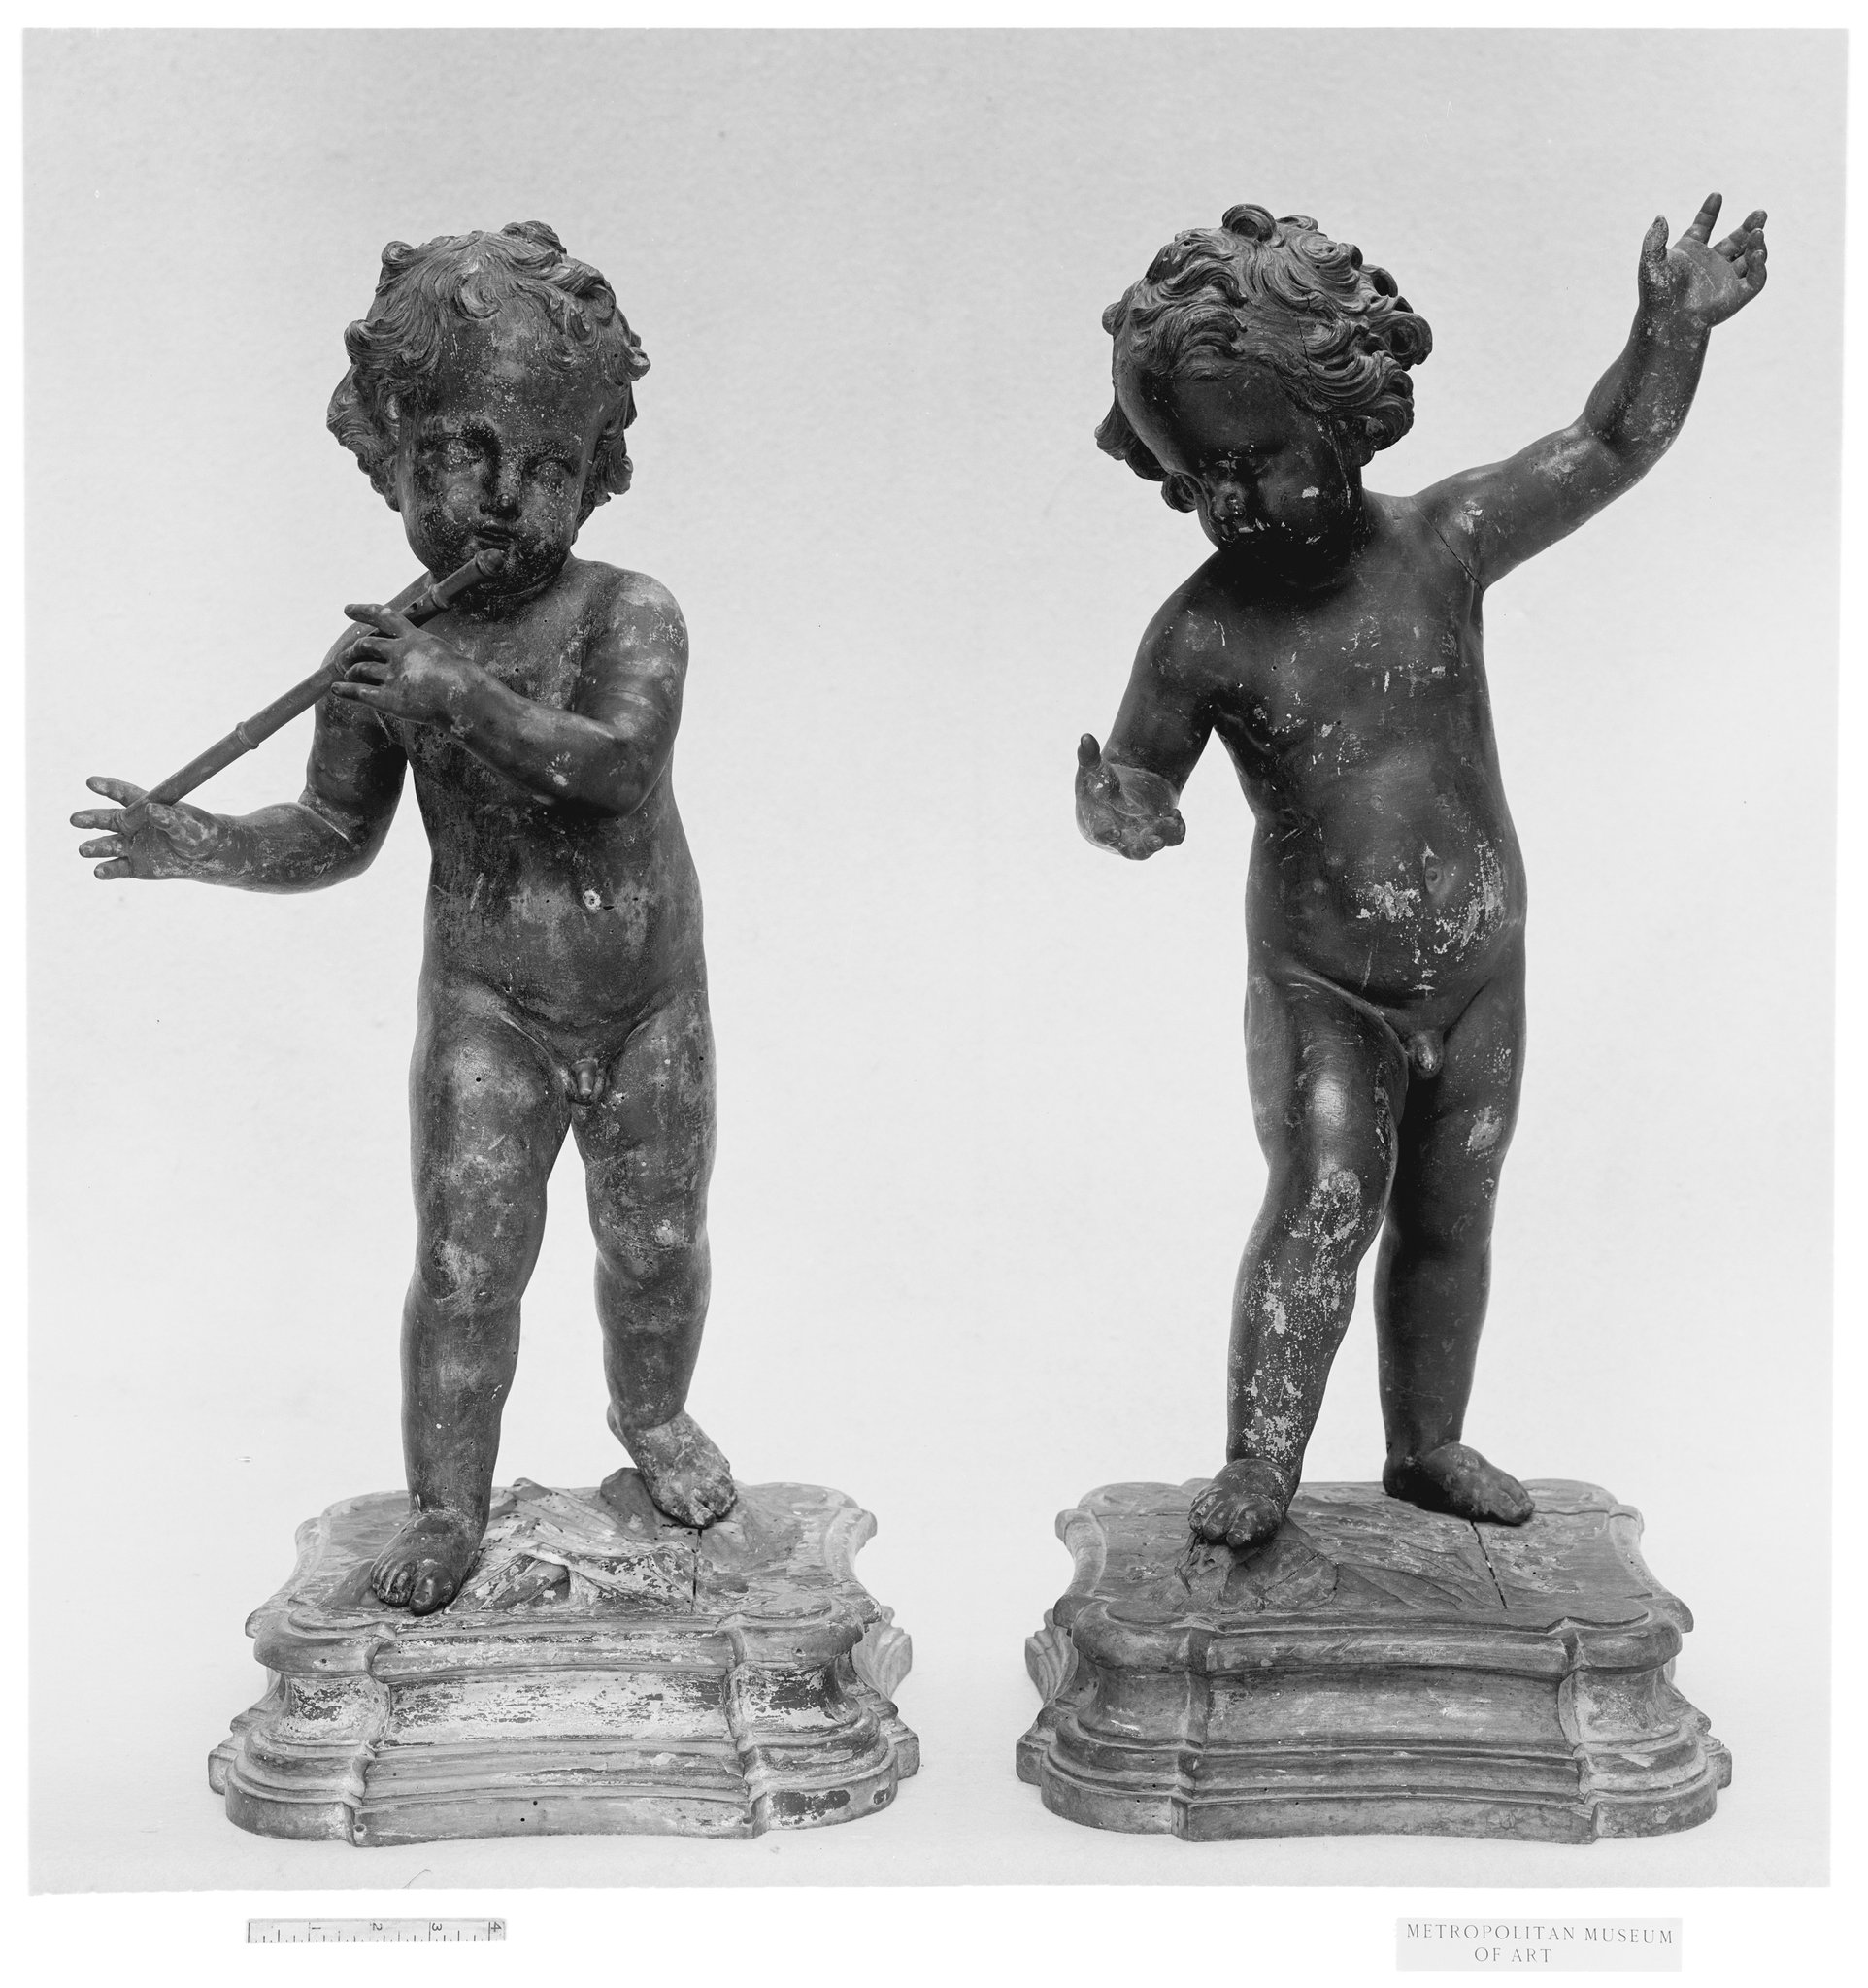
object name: statuette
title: Nude child playing a flute (one of a pair)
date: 1701-1733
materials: wood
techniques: carving, painting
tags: boys,male nudes,flutes